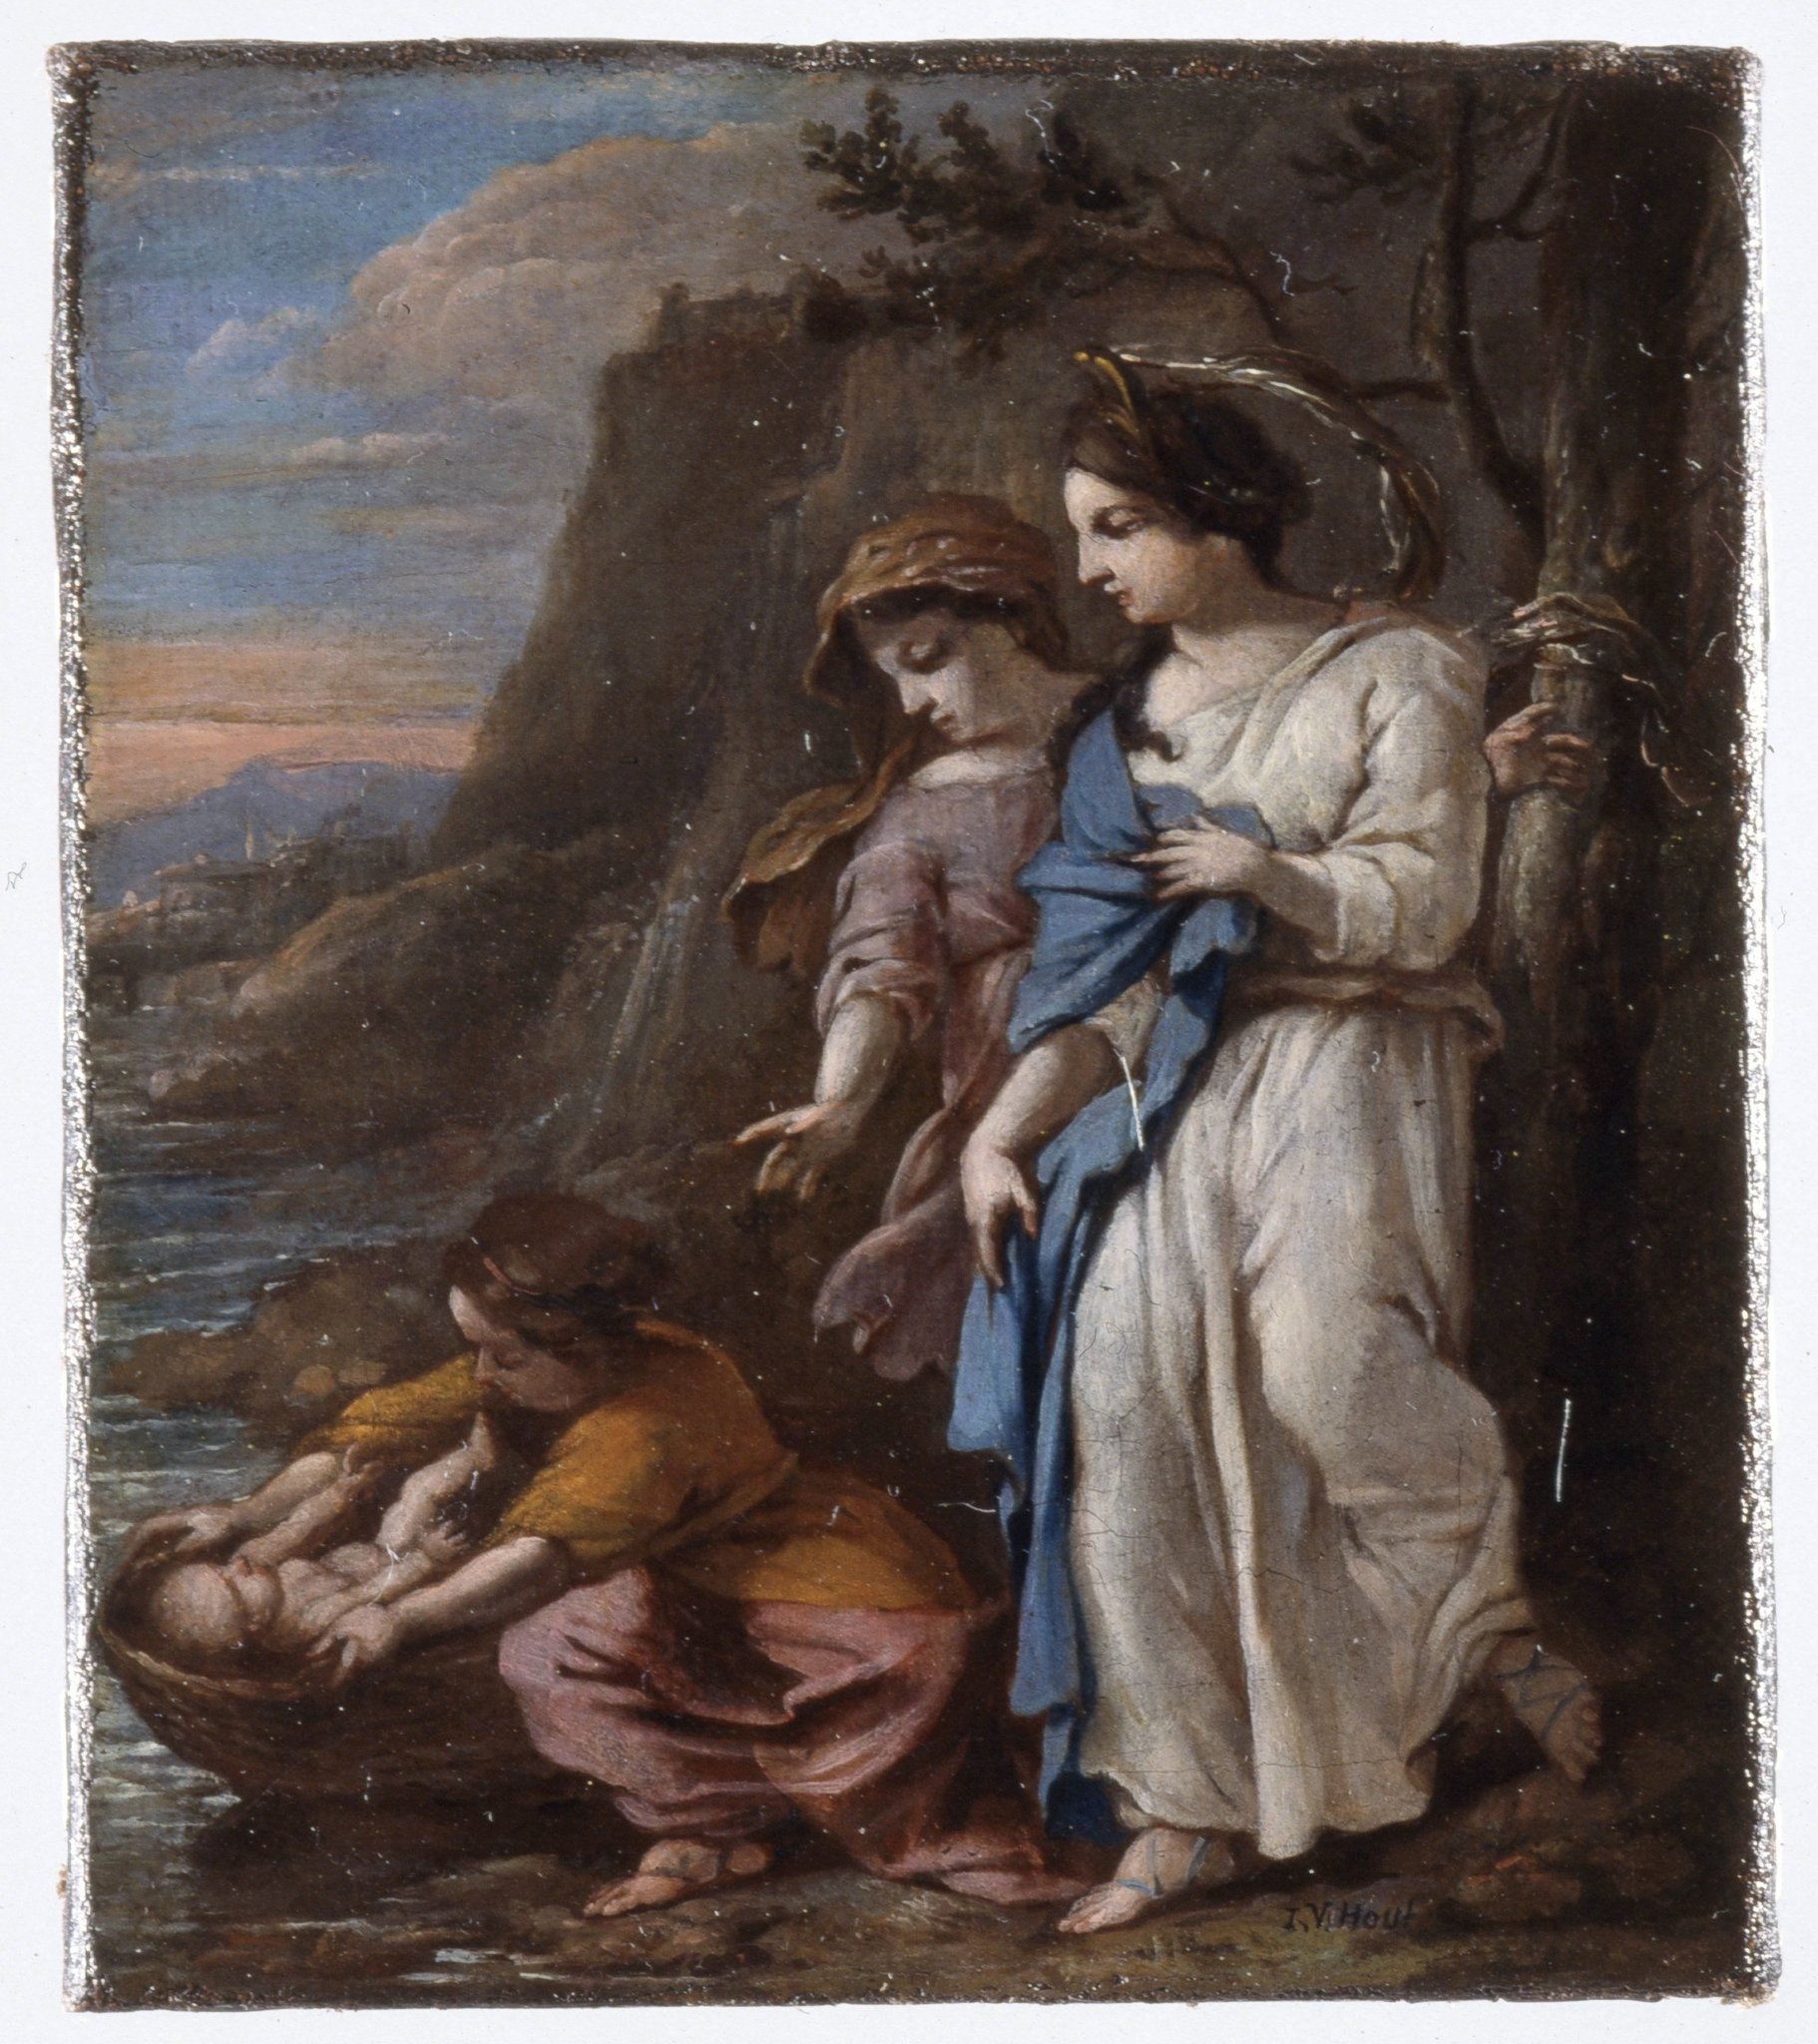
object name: painting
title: Finding of Moses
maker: johannes voorhout (i)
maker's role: draughtsman, painter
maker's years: 1647-1723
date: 1690-1710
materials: canvas, oil, paint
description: Schoorsteenstuk in de kraamkamer van een poppenhuis; voorstellende bijbelse historie van Farao's dochter, begeleid door twee hofdames, die het kindje Mozes vindt in een mandje aan de oever van de Nijl. De scène vindt plaats in een bergachtige omgeving, met links op de achtergrond gebouwen.